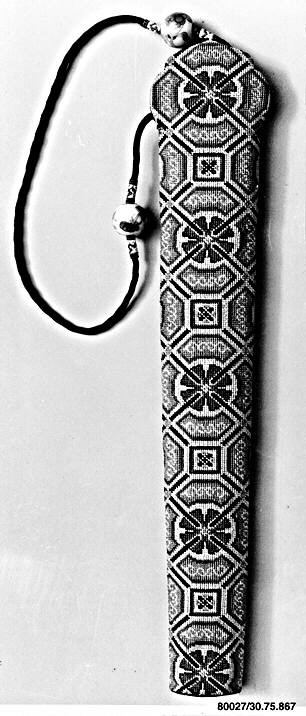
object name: fan holder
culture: chinese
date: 1701-1900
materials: silk